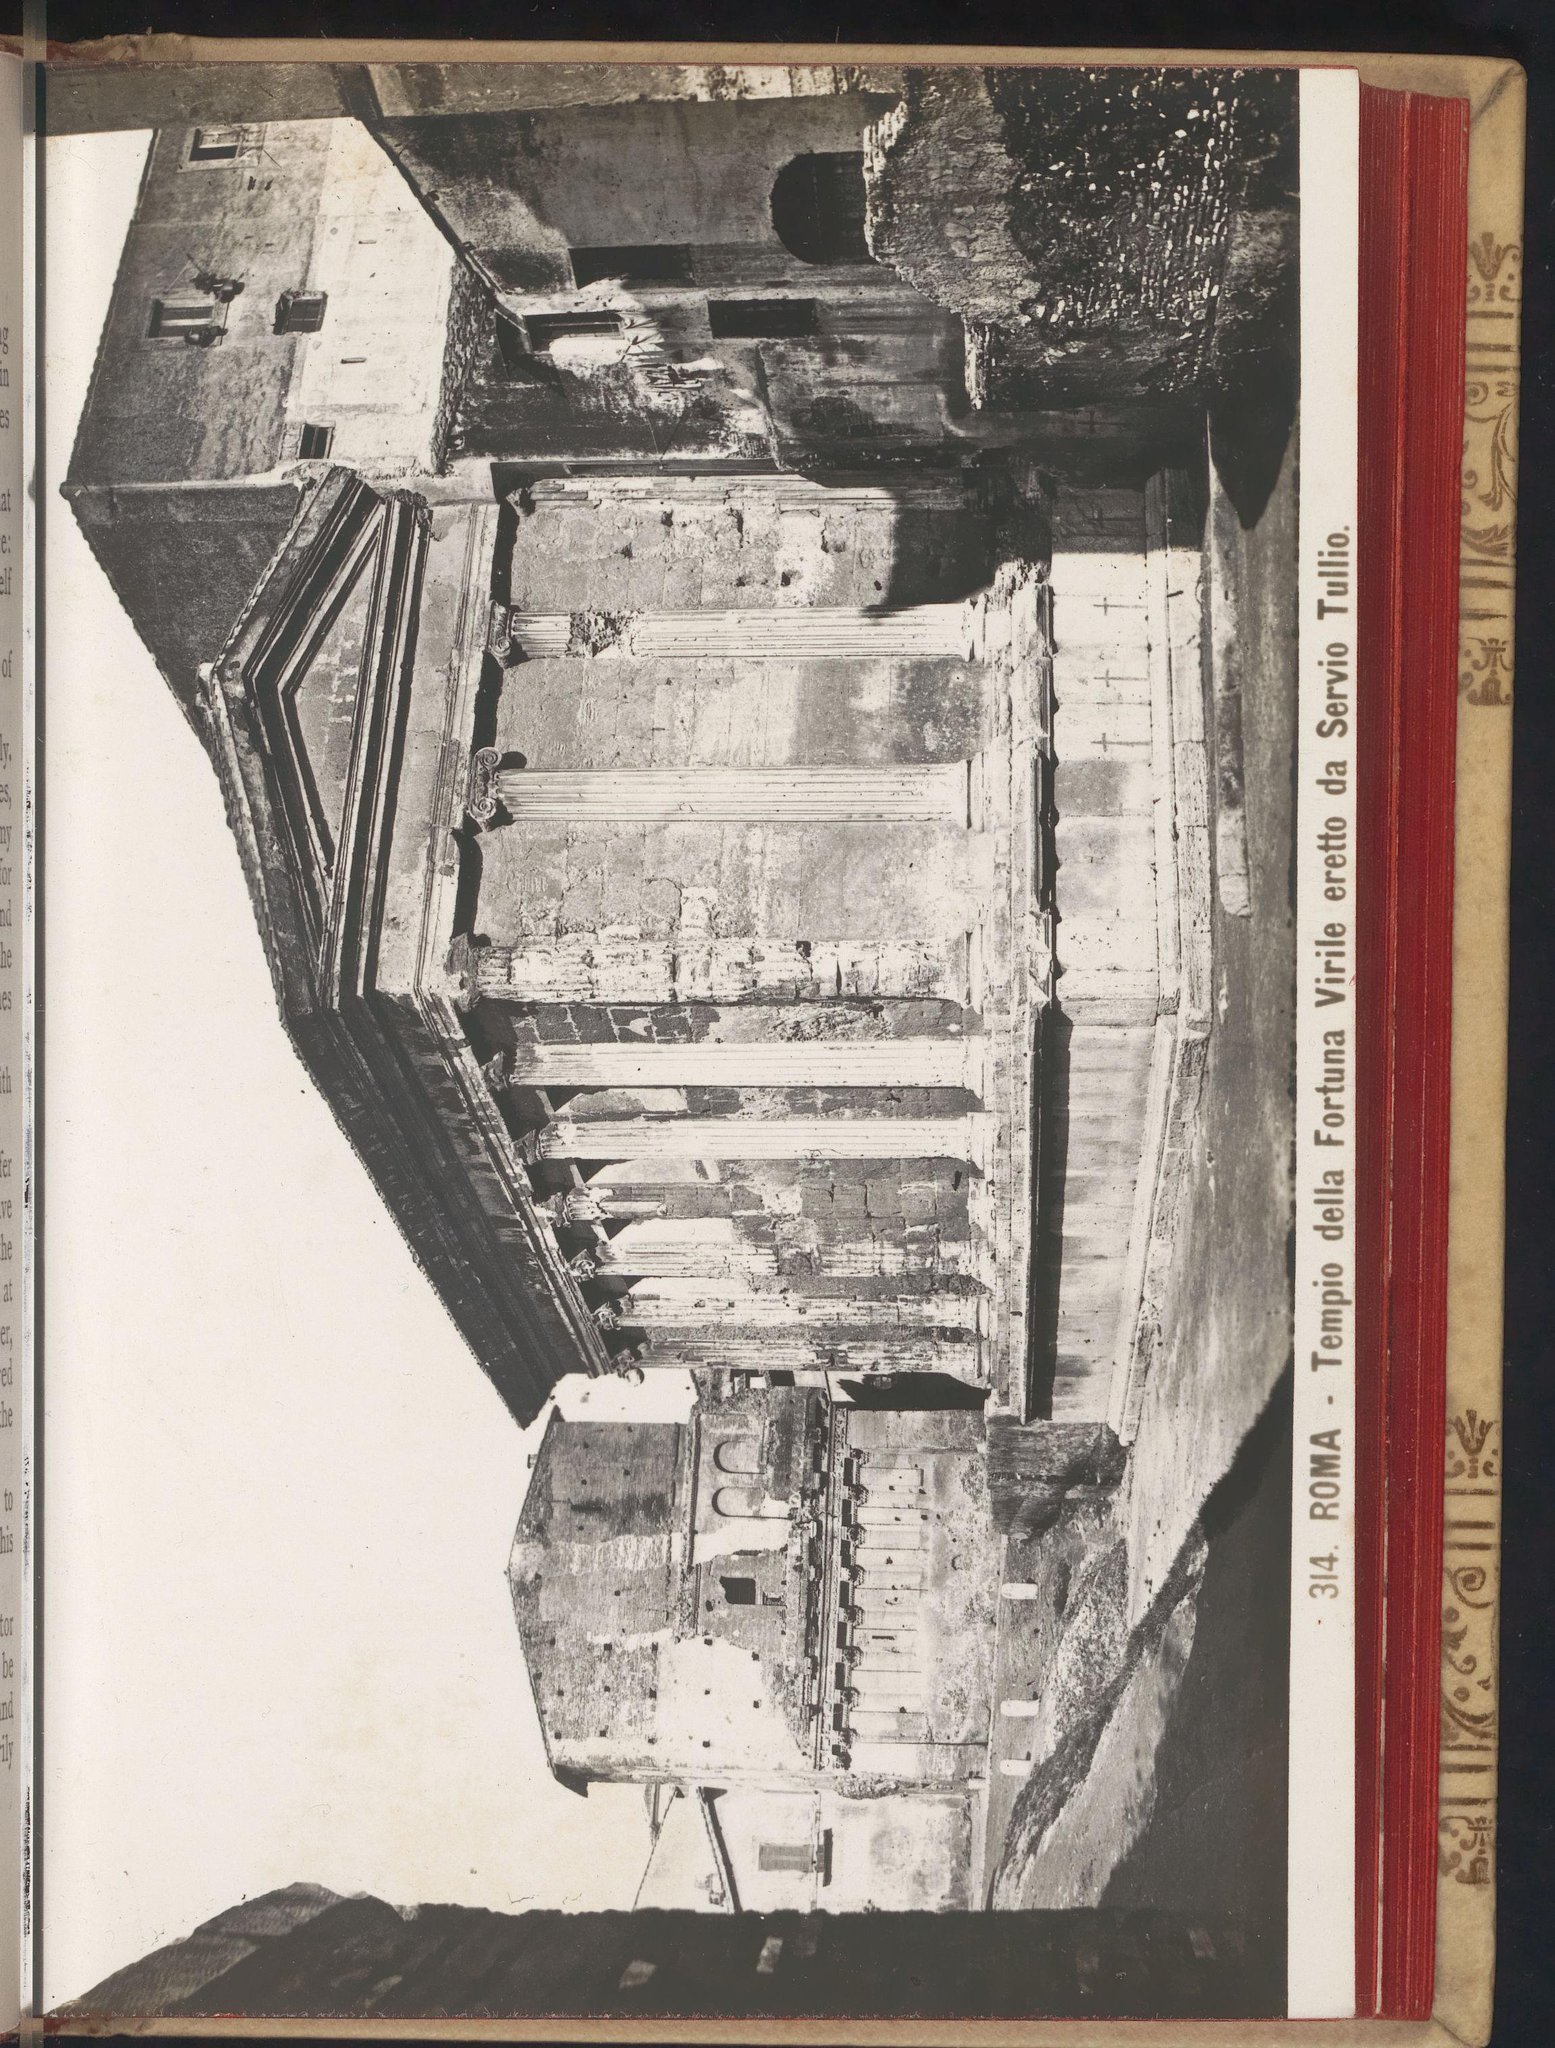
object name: page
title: Exterieur van de Tempel van Portunus te Rome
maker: Anonymous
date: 1895-1915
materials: photographic support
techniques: gelatin silver print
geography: rome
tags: church (exterior), façade (of house or building)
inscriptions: number: ‘314.’